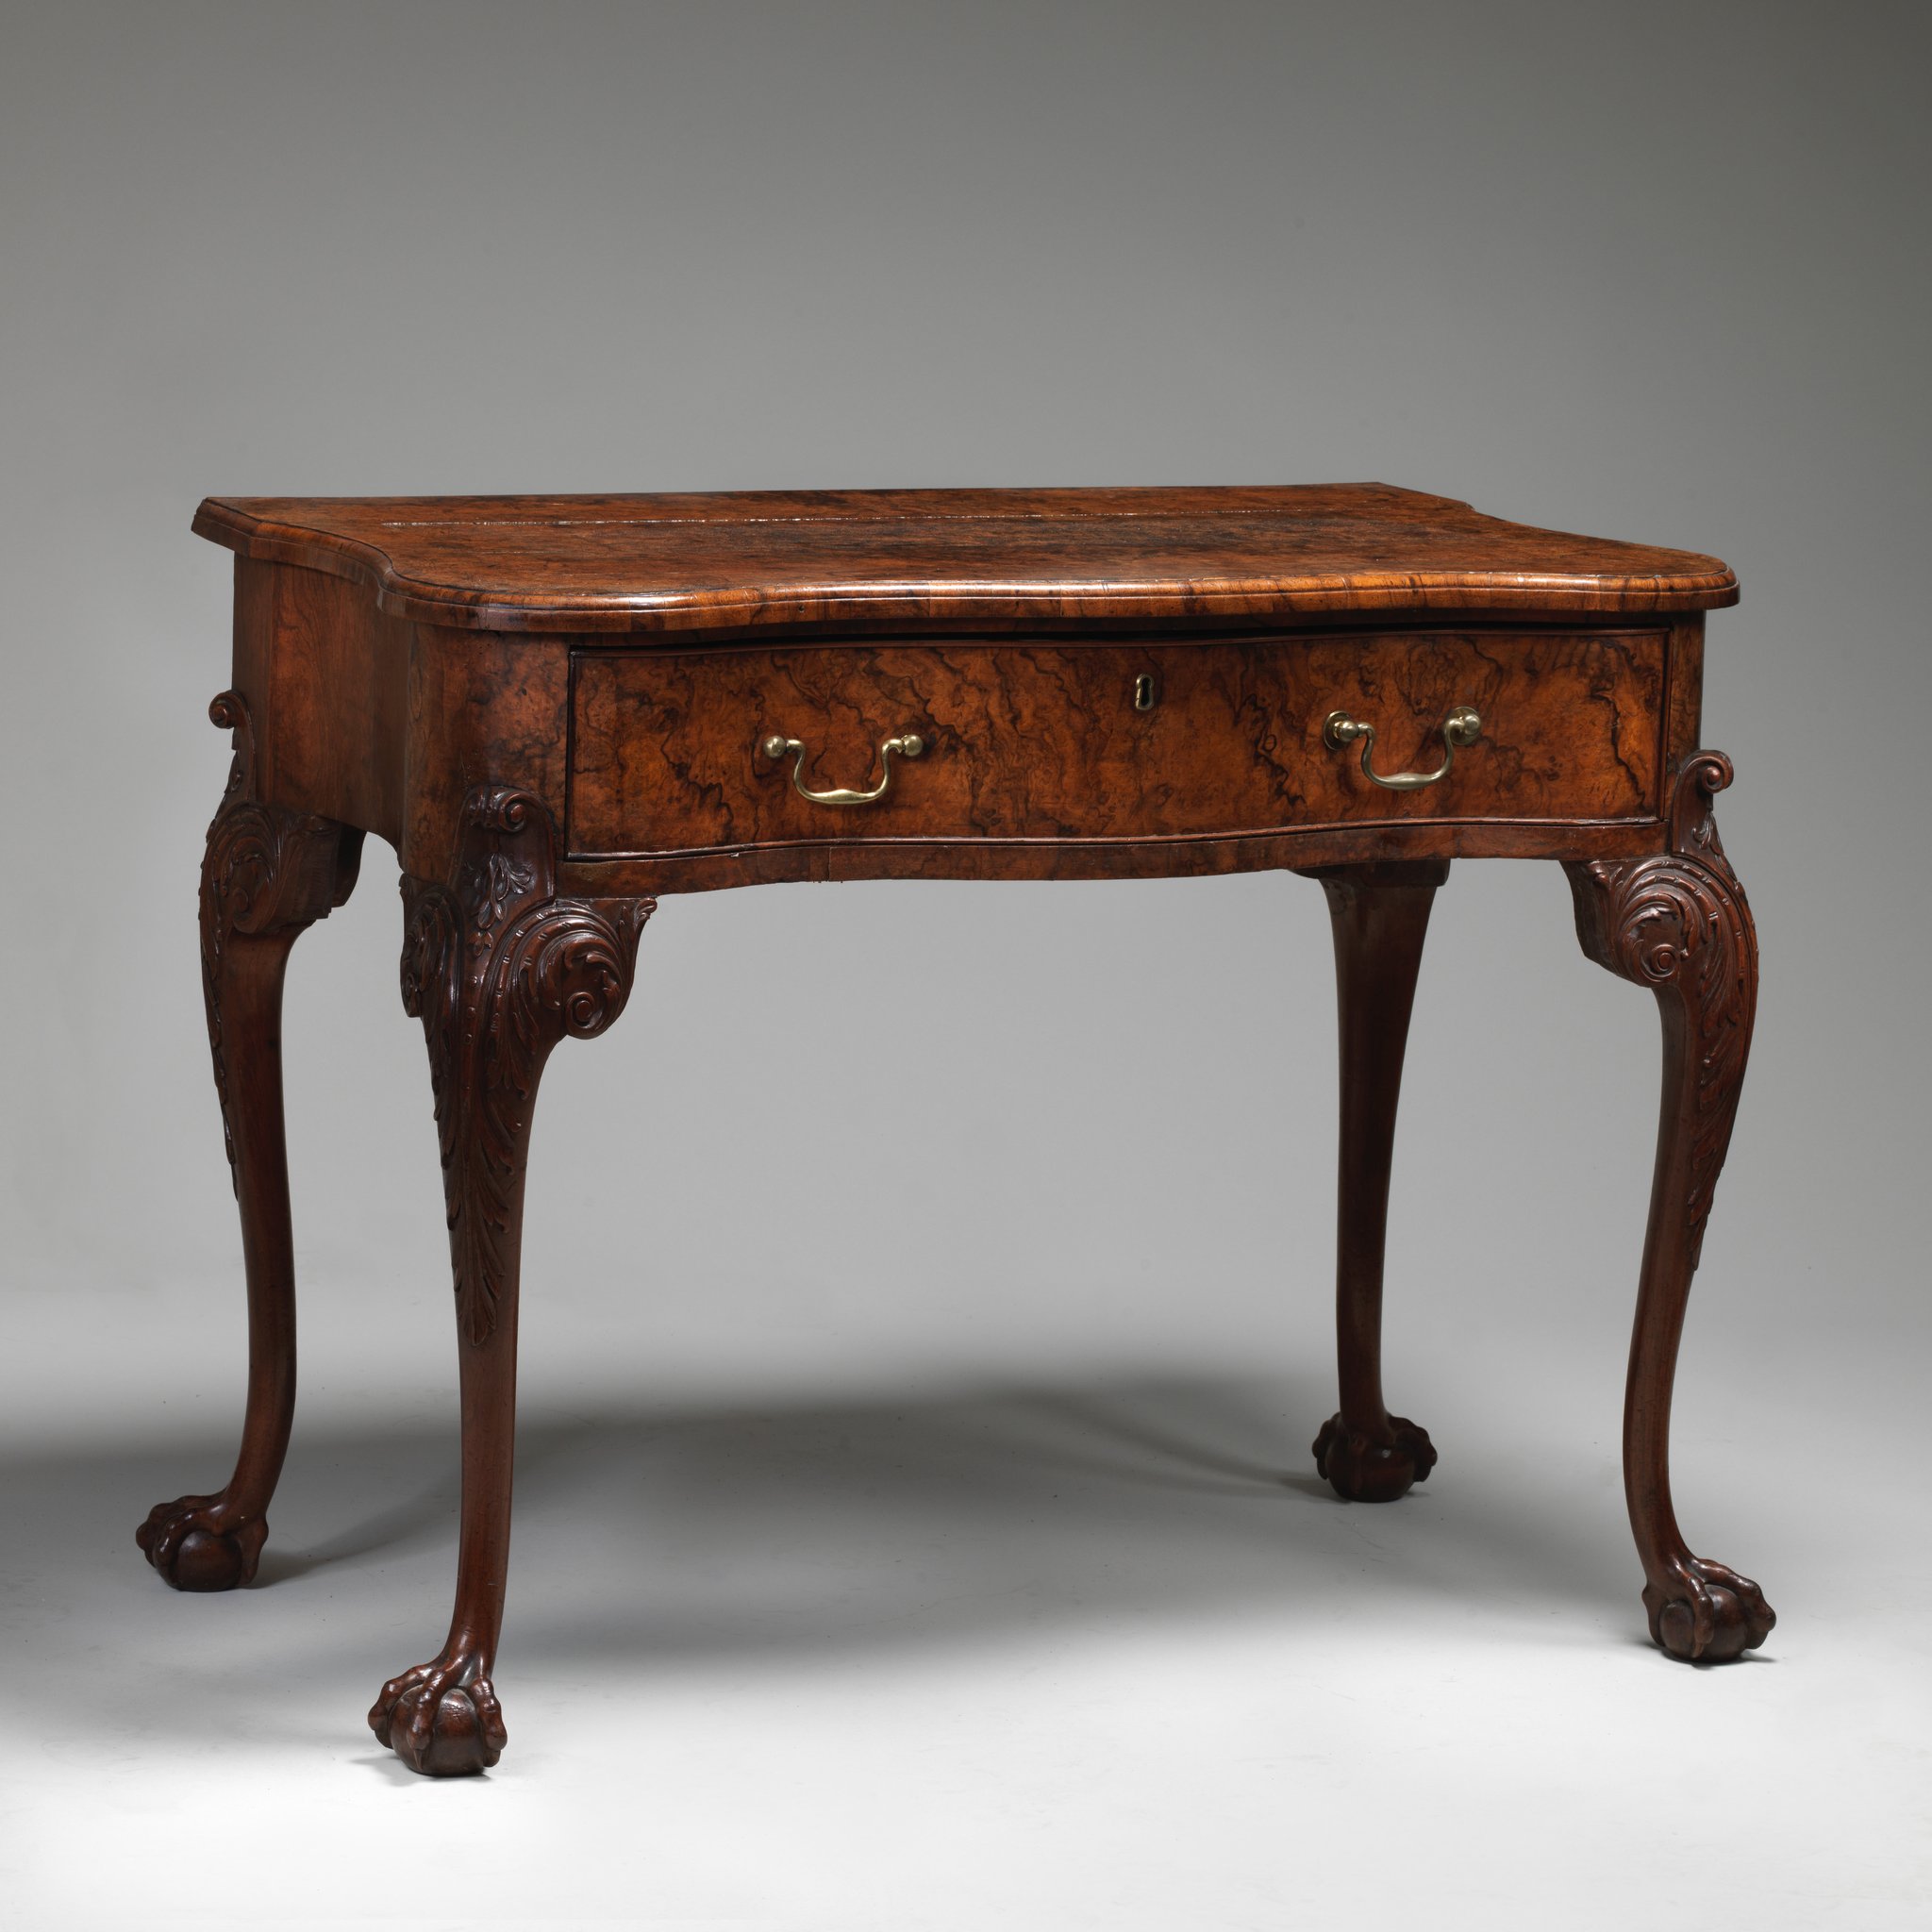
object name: side table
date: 1735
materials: brass, wood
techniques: veneering